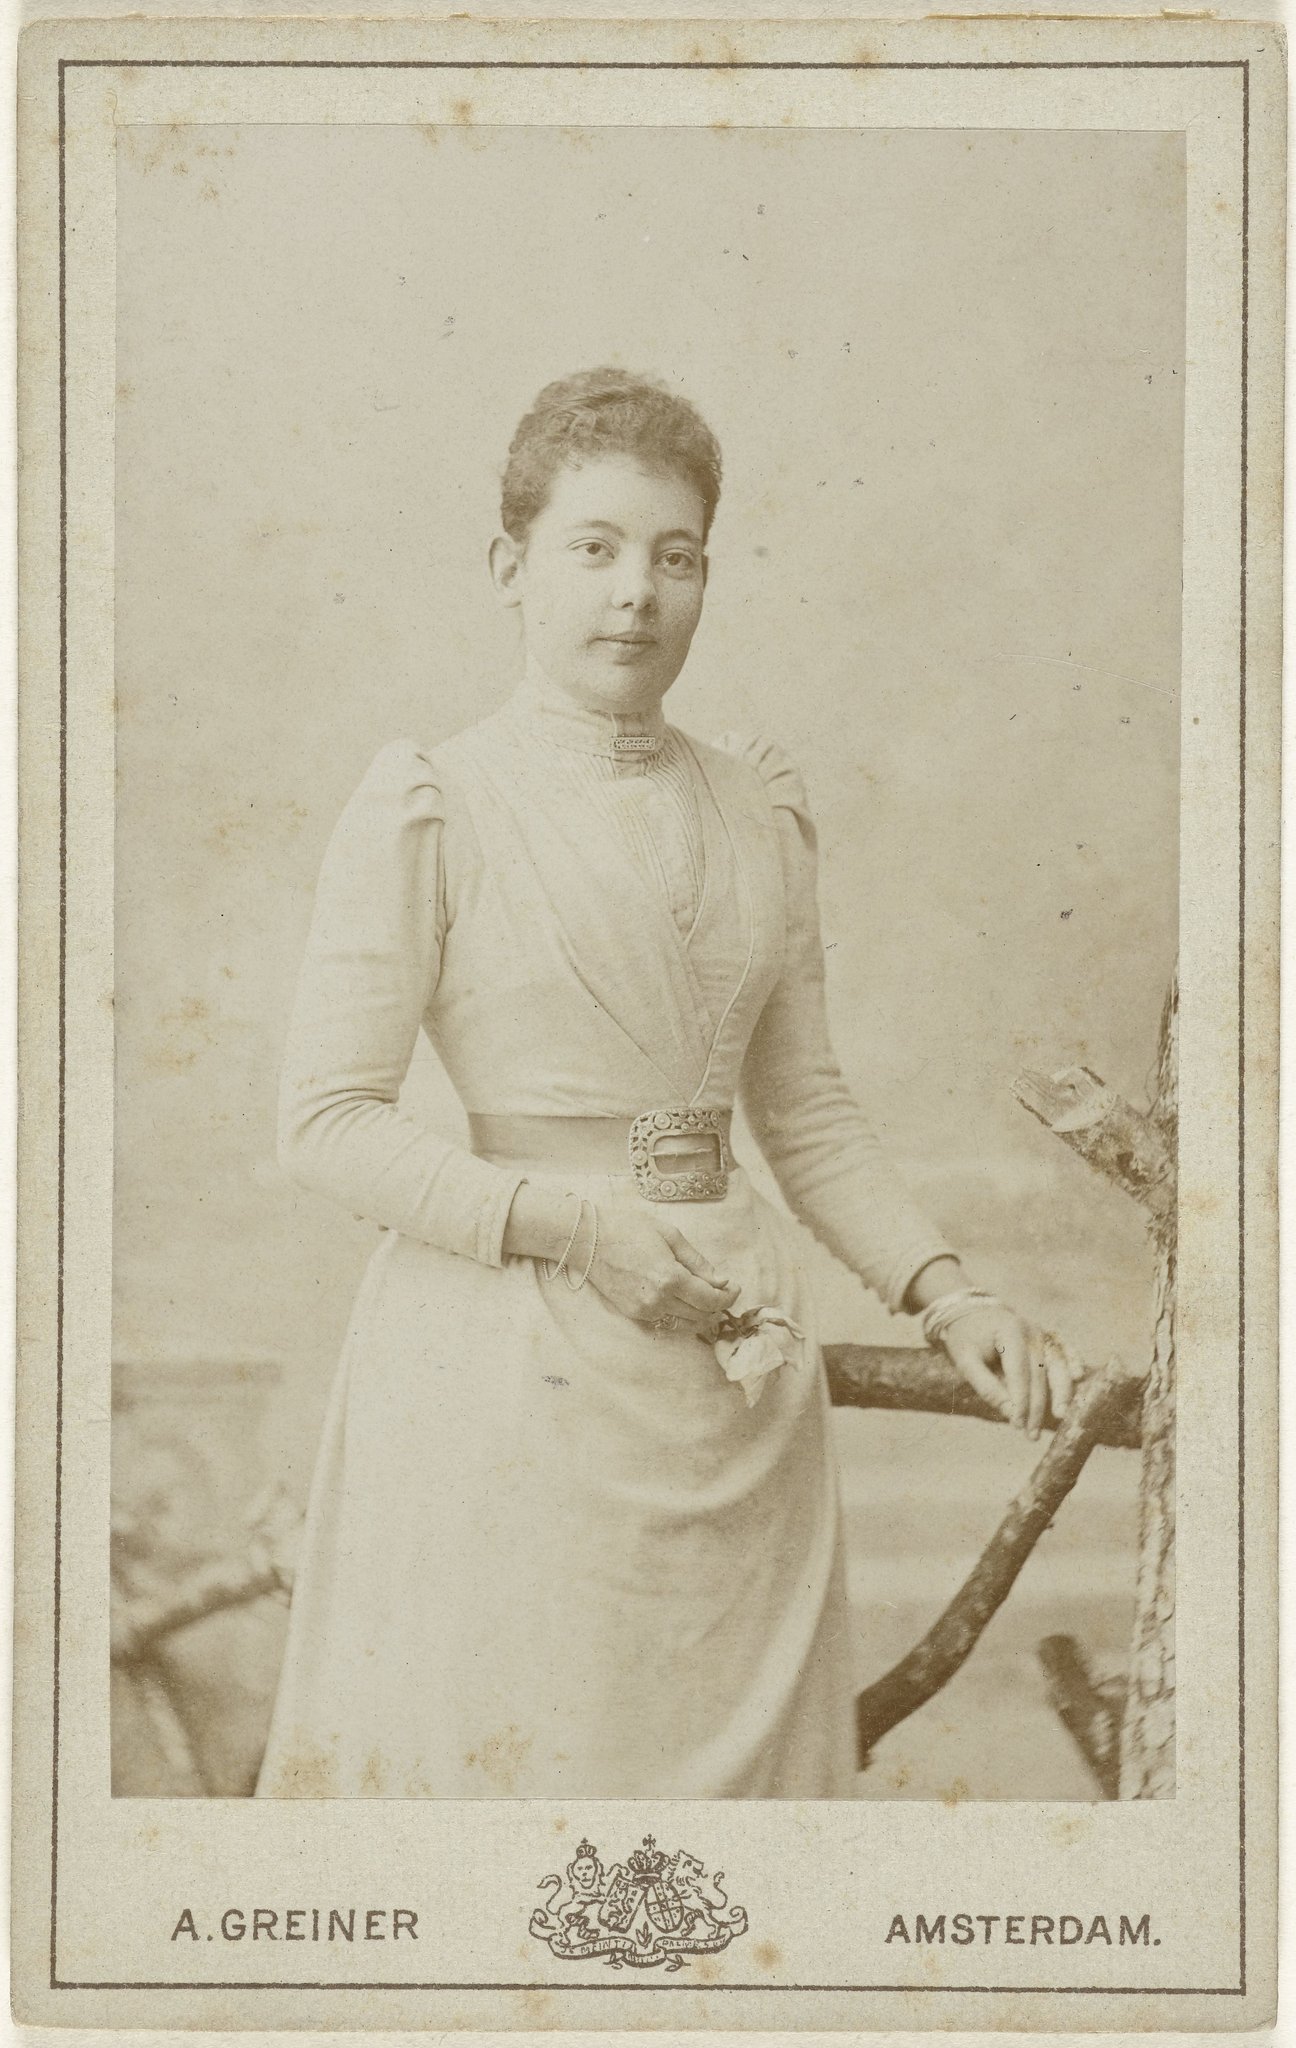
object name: photograph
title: Studioportret van een jonge vrouw in hooggesloten jurk met pofmouwen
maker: albert greiner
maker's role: fotograaf, fotostudio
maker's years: 1833-1890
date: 1890-1915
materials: paper, photographic support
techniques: photography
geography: amsterdam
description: Studioportret van een jonge vrouw in hooggesloten jurk leunend tegen een hek. Om haar middel draagt ze een ceintuur, in haar hand houdt ze een bloem.